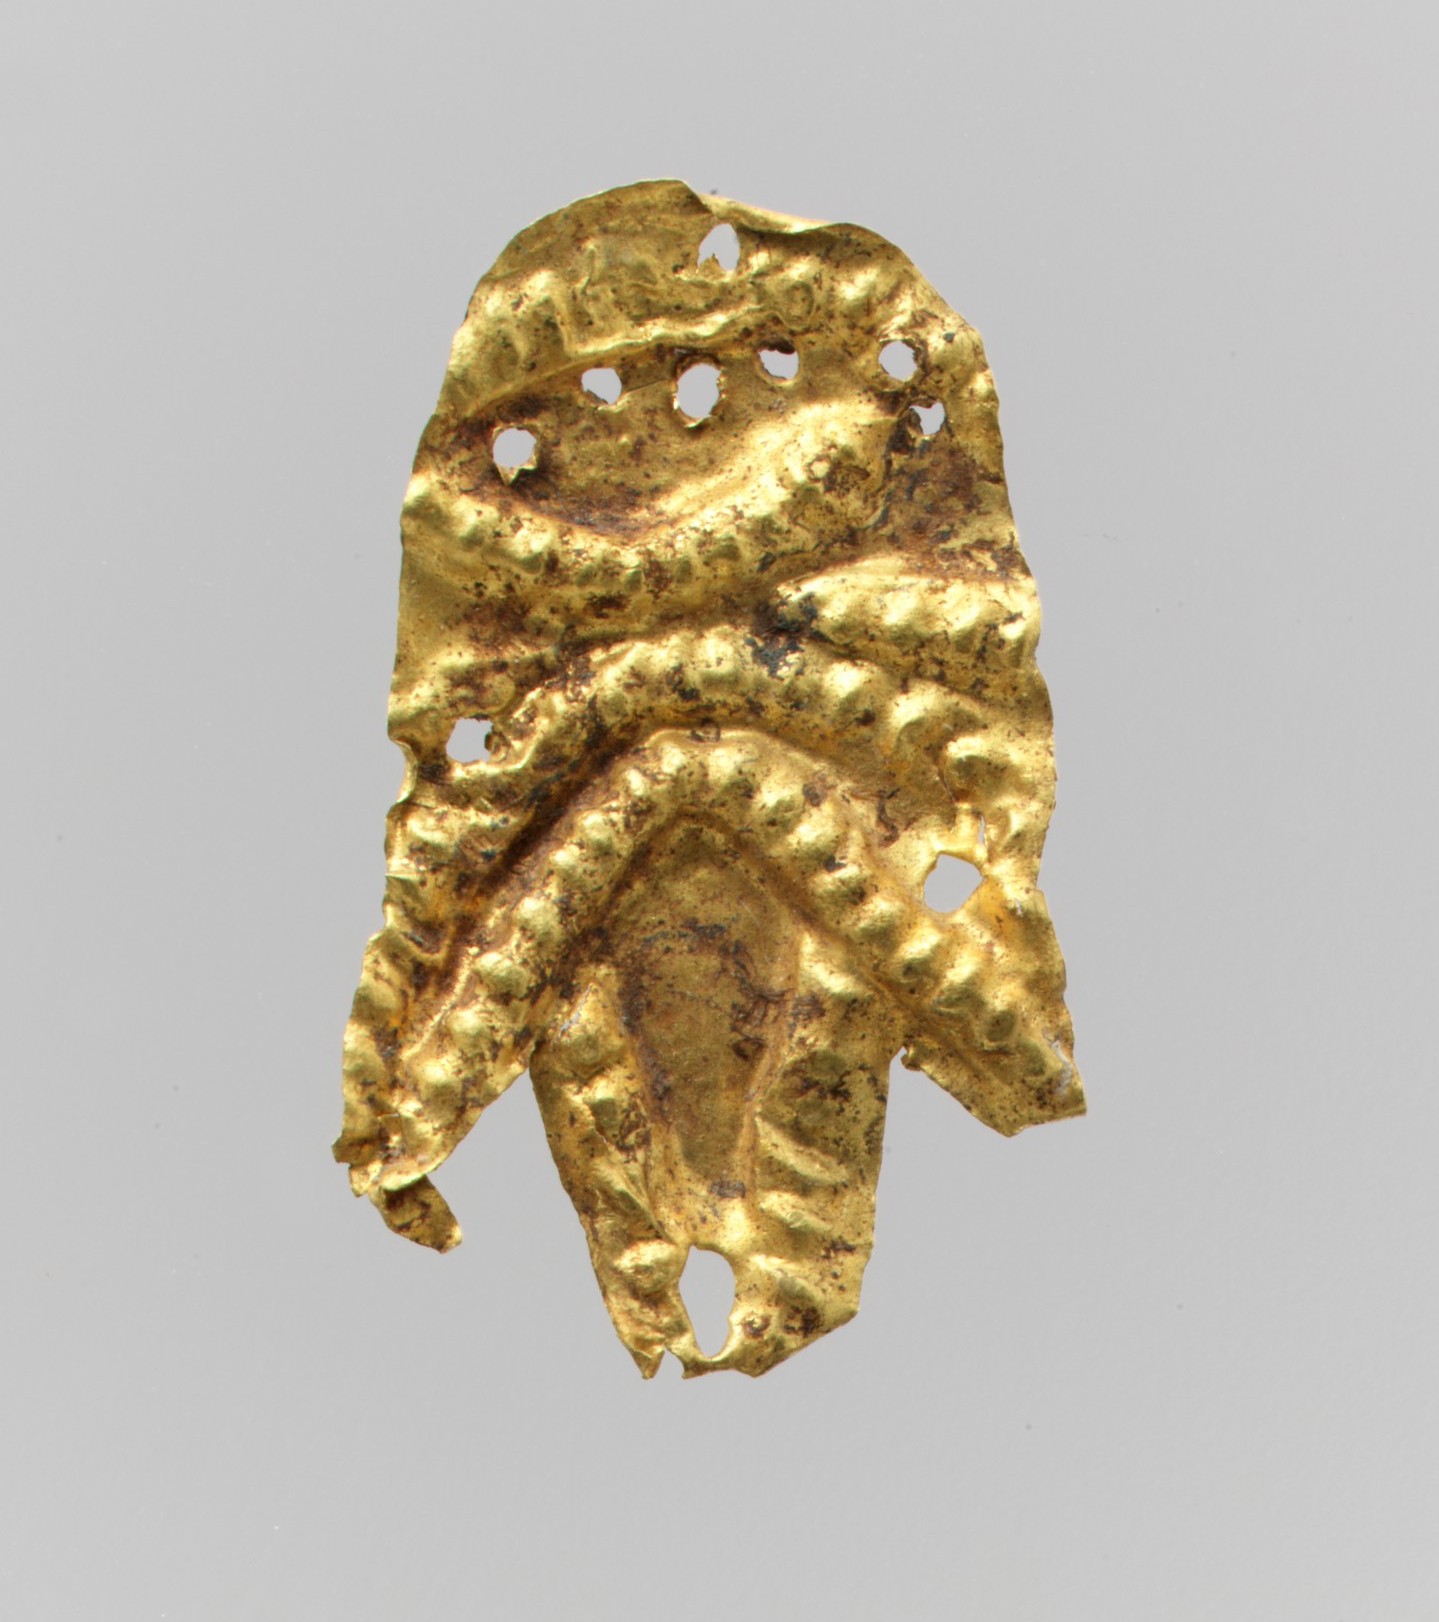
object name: bead ornament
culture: roman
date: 201-300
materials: gold